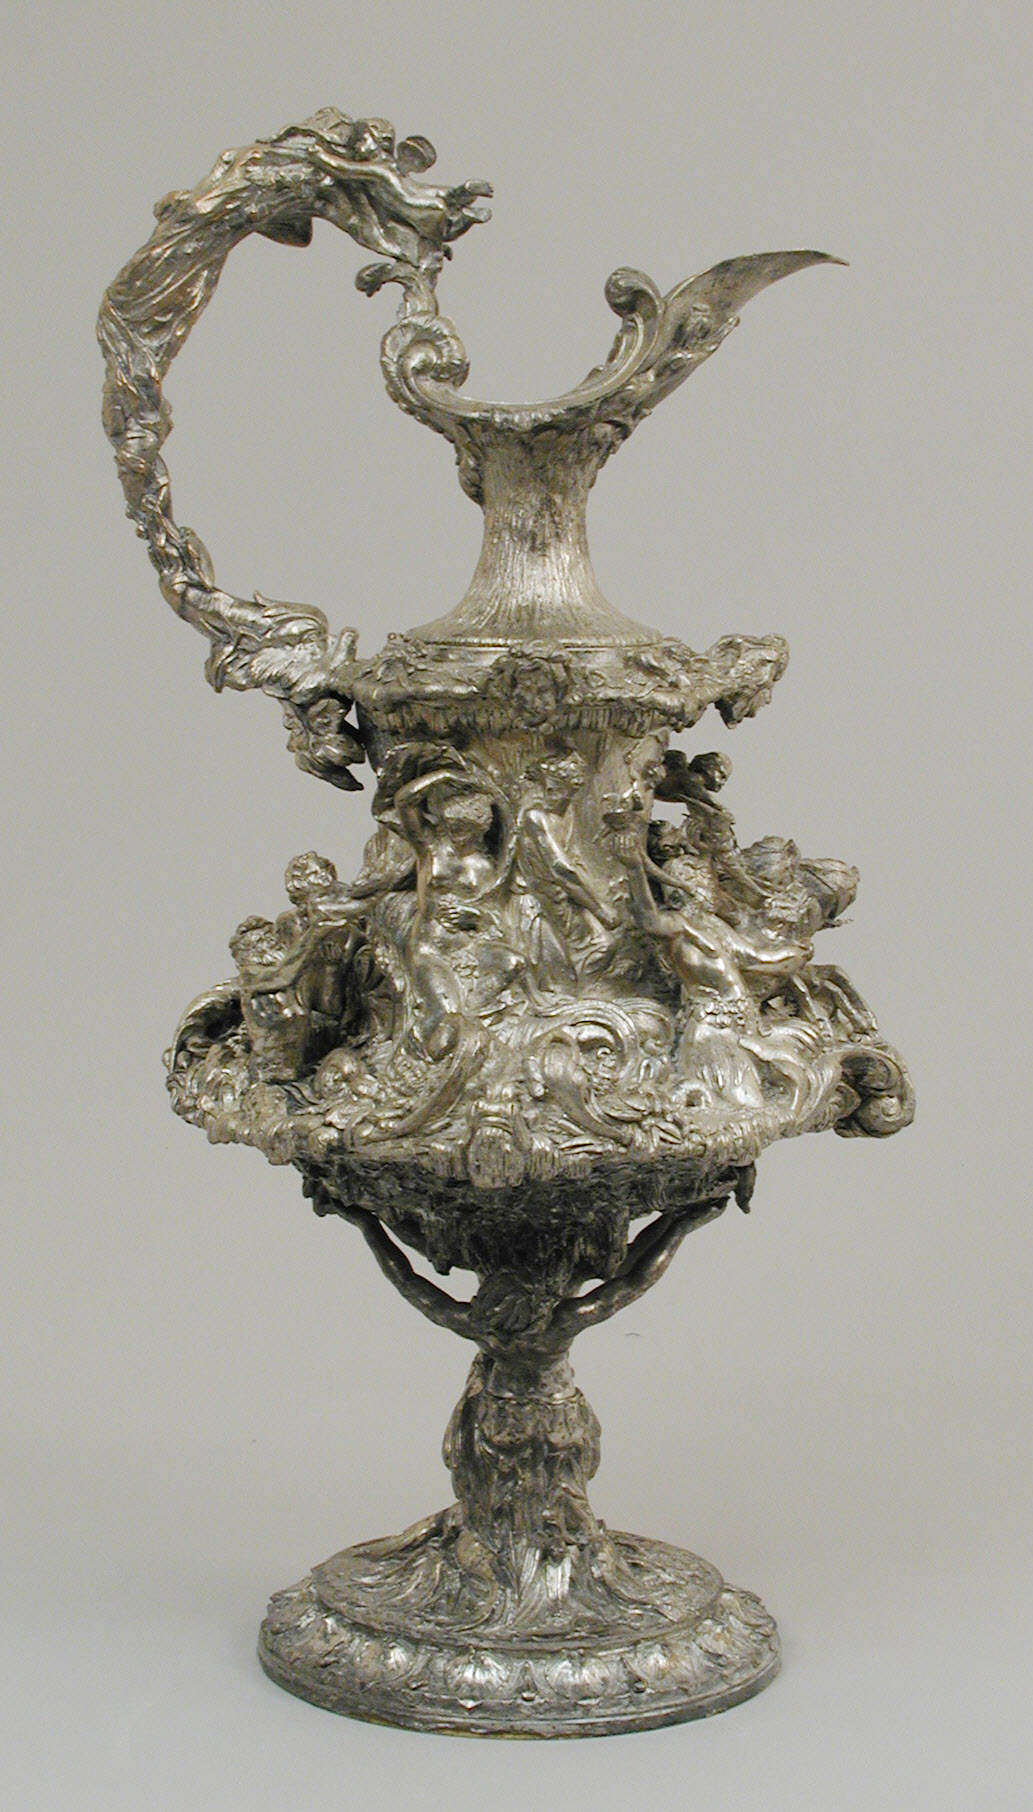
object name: ewer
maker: alexandre gueyton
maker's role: maker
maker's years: 1800-1900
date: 1801-1900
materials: metal, silver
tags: men,women,horses